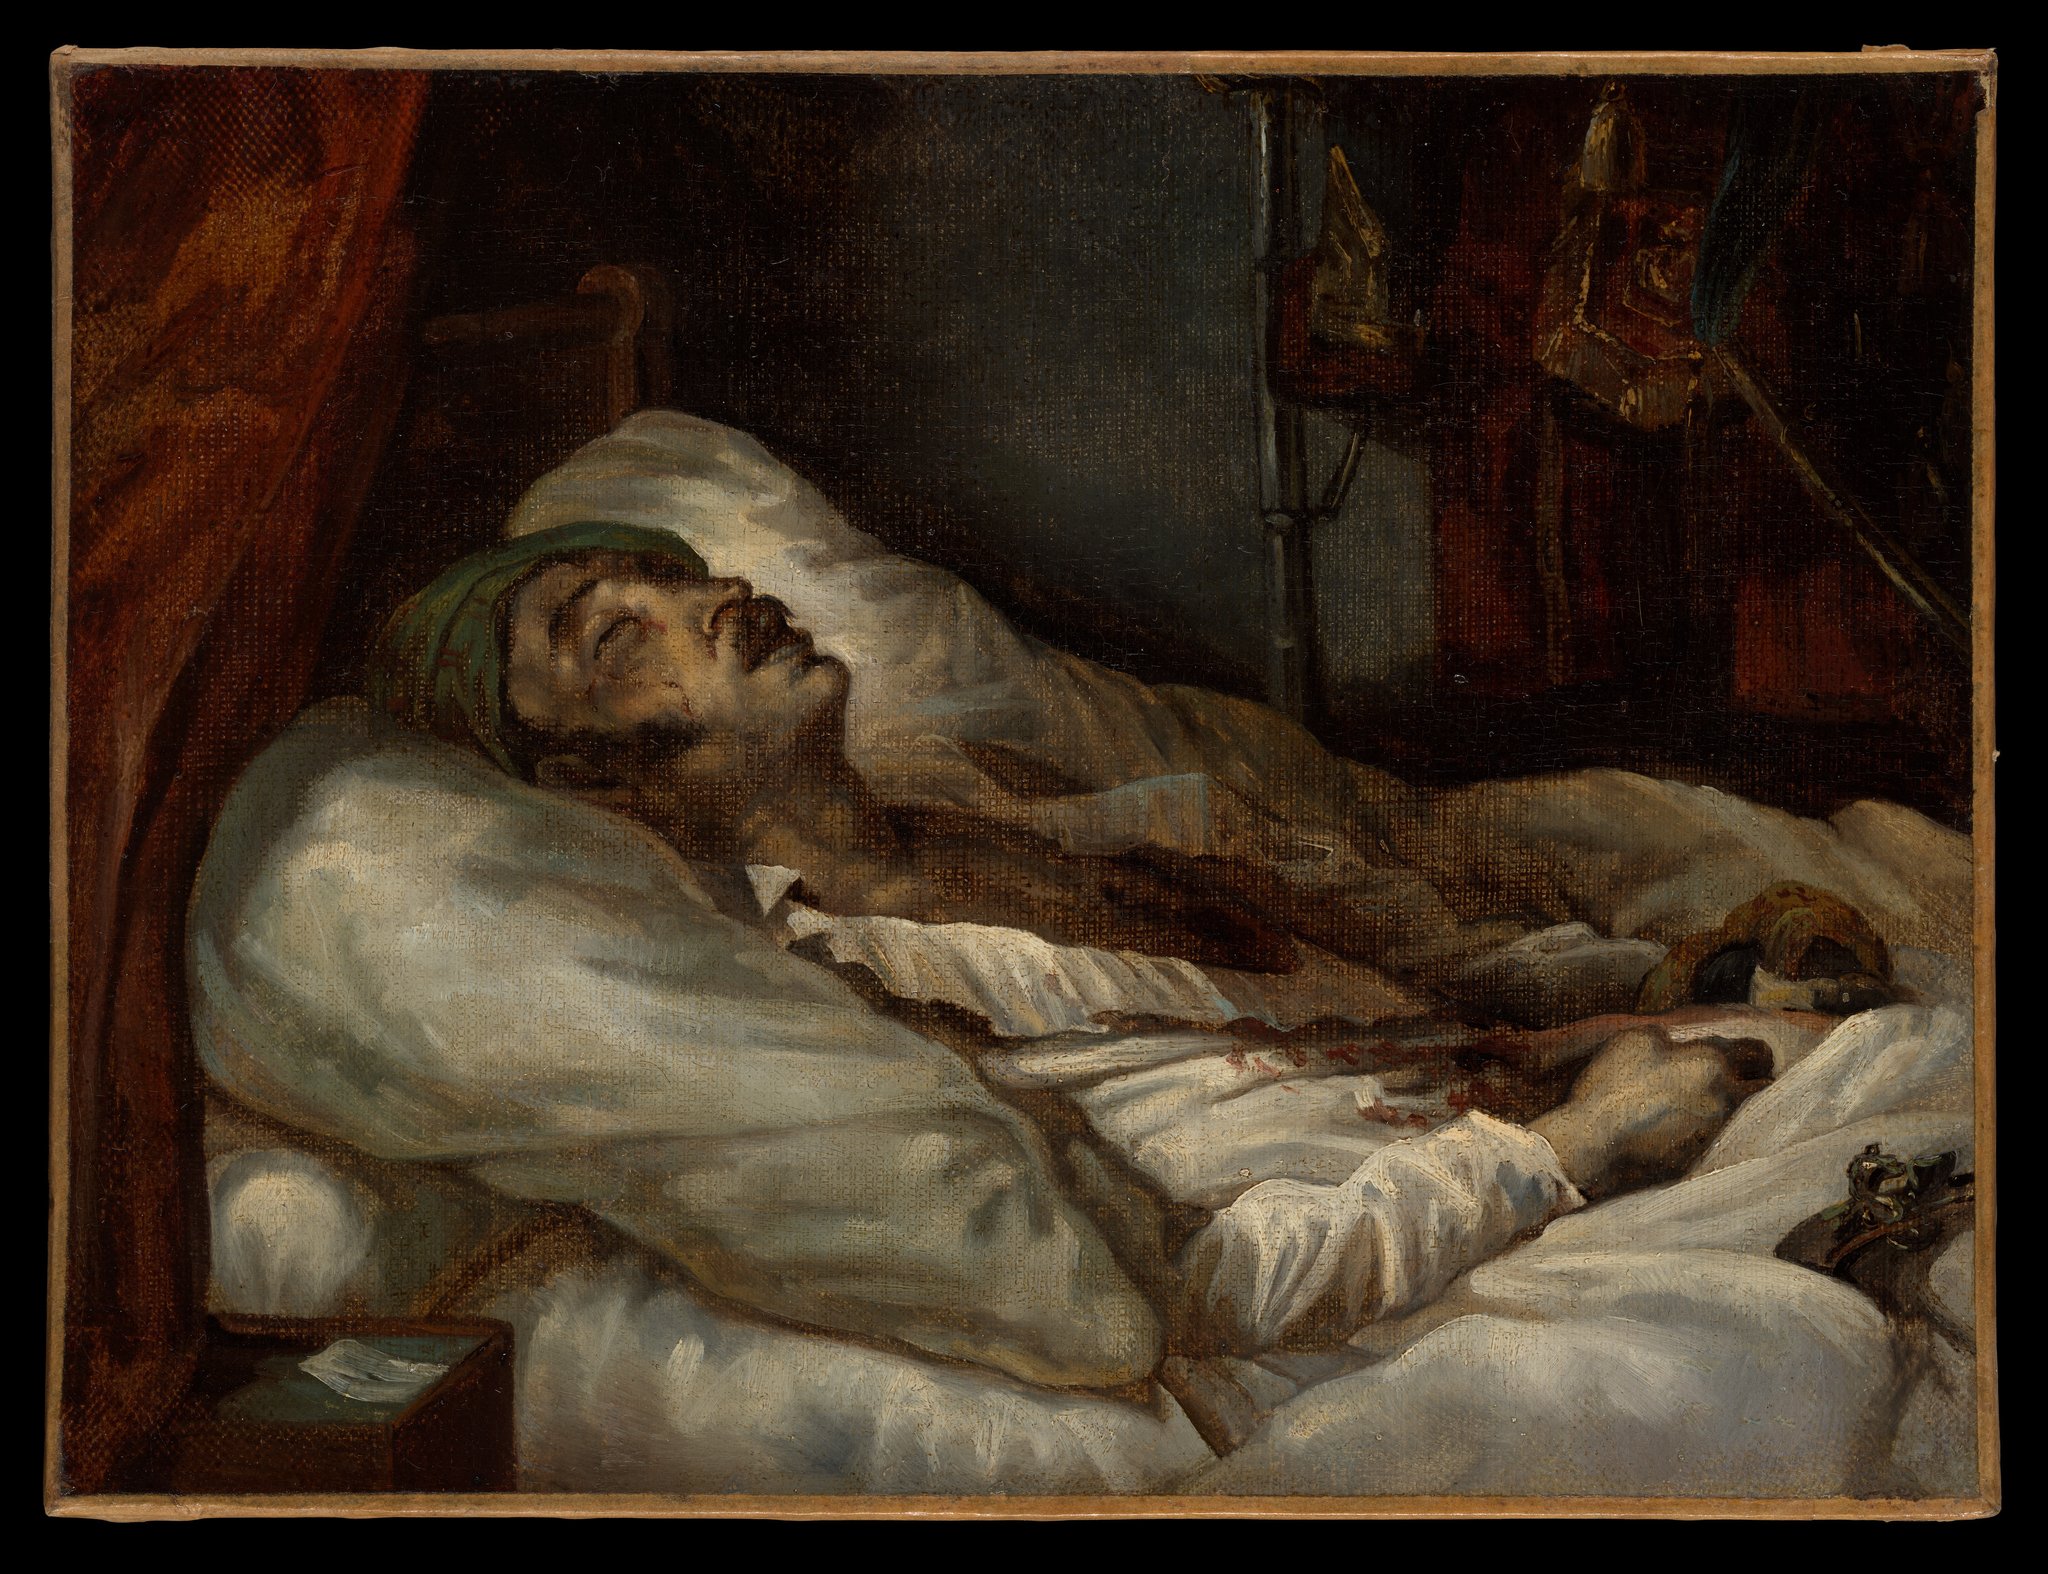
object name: painting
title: General Letellier on His Deathbed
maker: jean louis andré théodore géricault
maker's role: artist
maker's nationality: french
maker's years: 1791-1824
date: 1818-1820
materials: canvas, oil